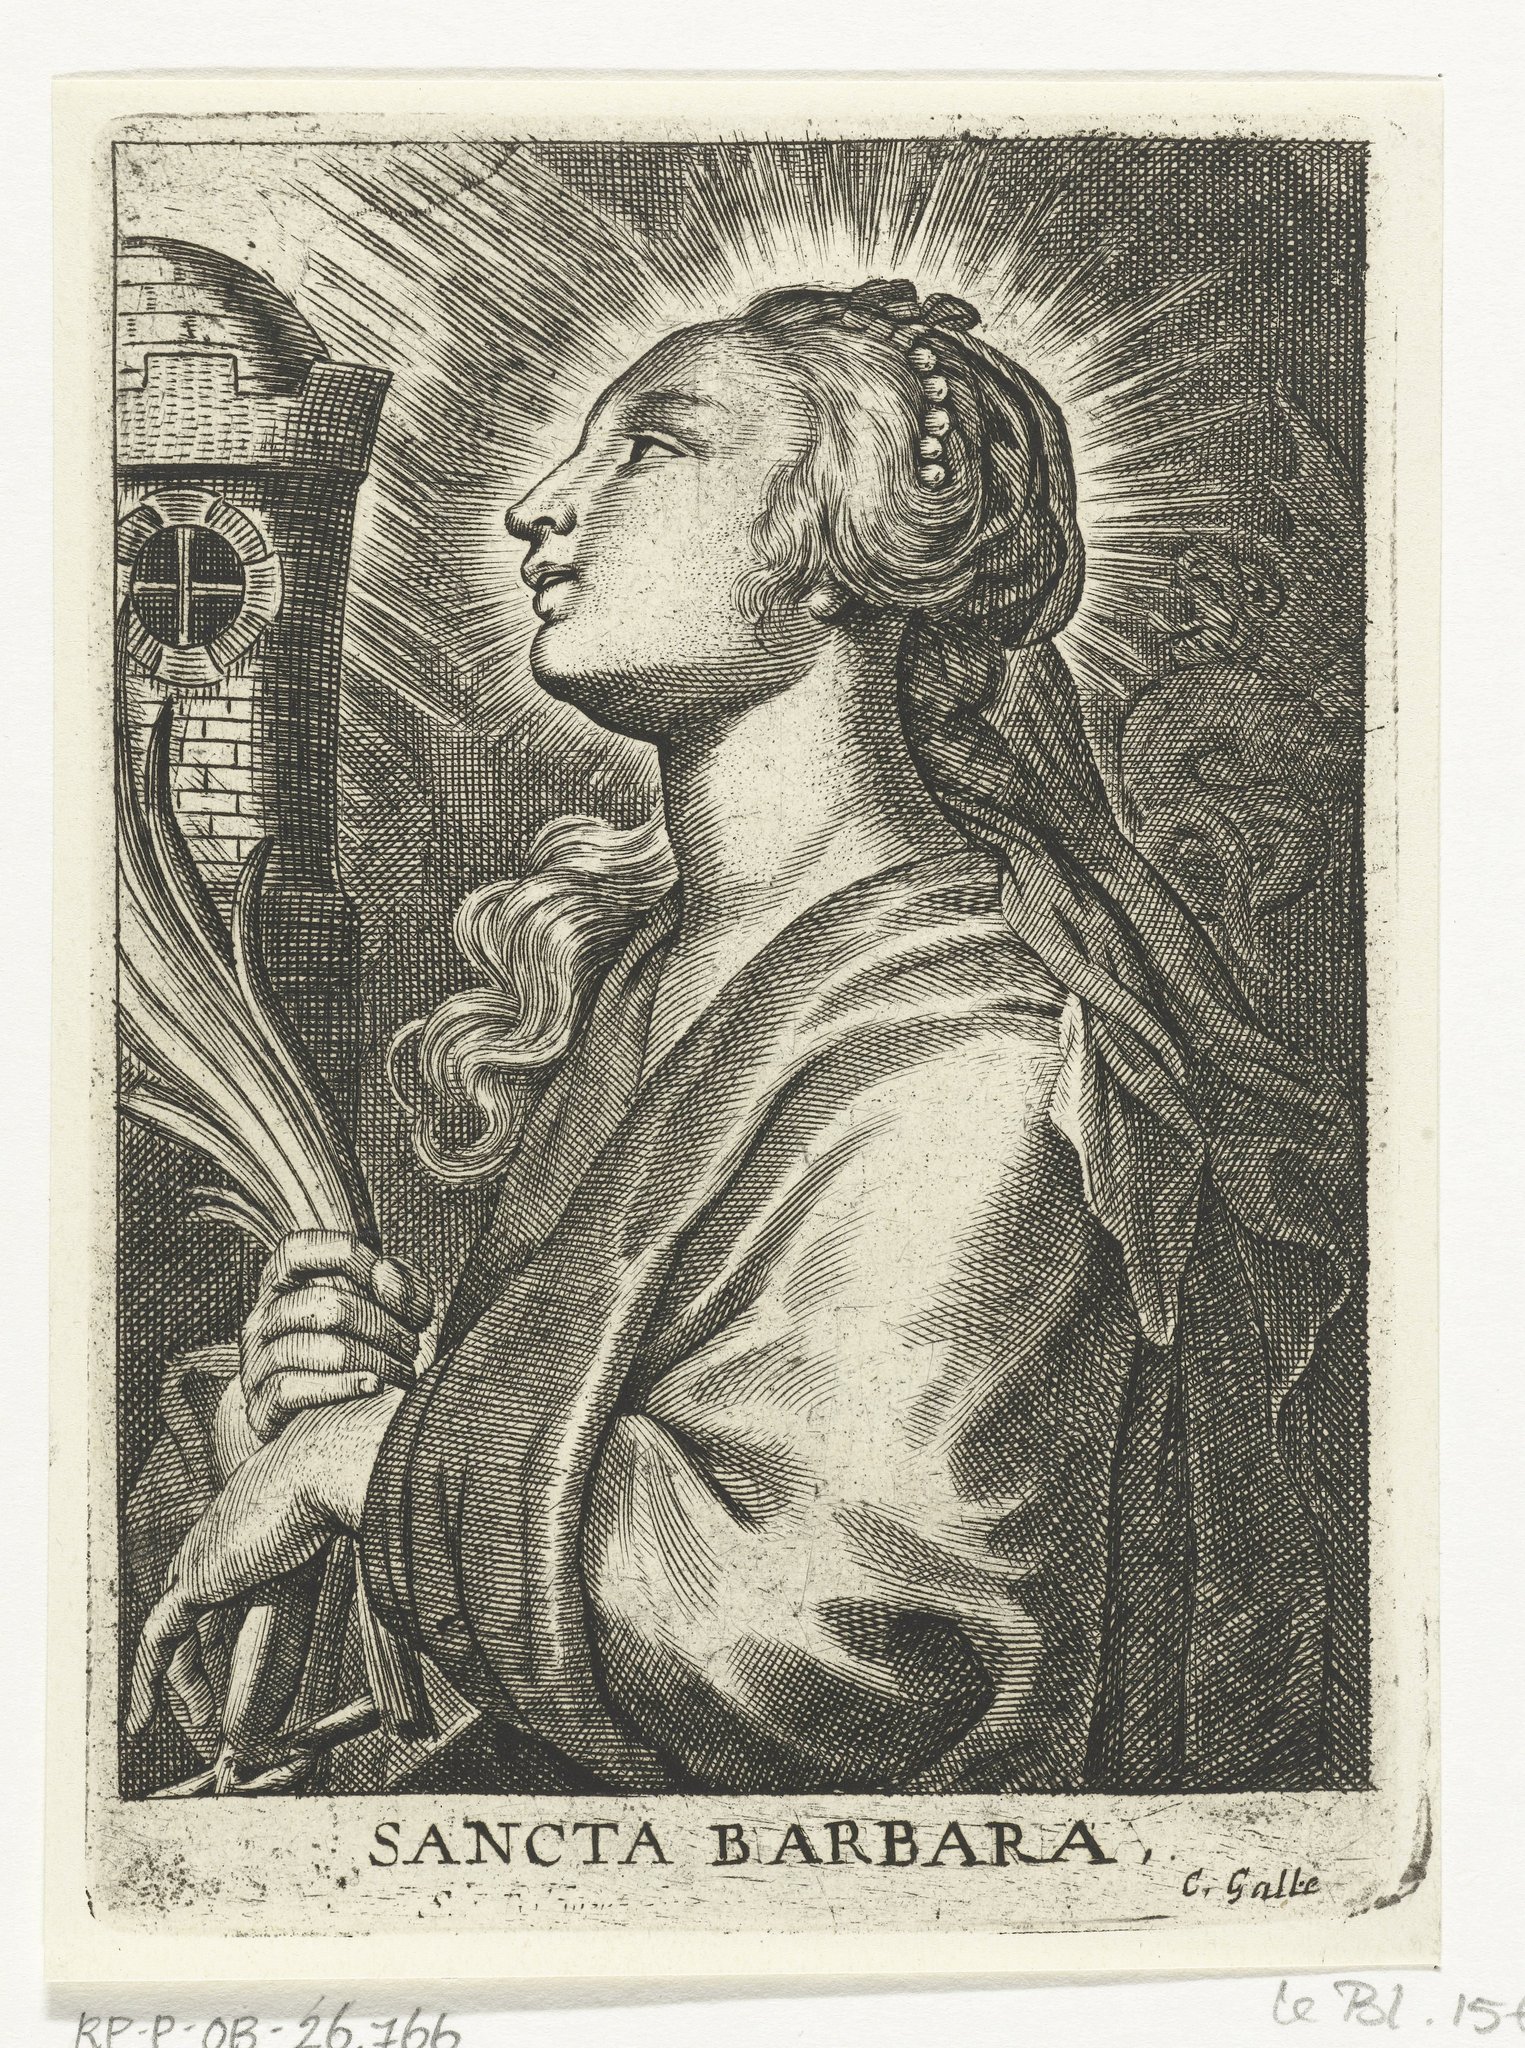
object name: print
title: Heilige Barbara met toren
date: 1596-1659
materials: paper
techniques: engraving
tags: the virgin martyr barbara; possible attributes: book, cannon(ball), crown, cross, chalice with wafer, dioscuros (her father), peacock feather, sword, torches, mason's tools, tower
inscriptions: collector's mark: Lugt 2228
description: Prent naar ontwerp van Peter Paul Rubens.